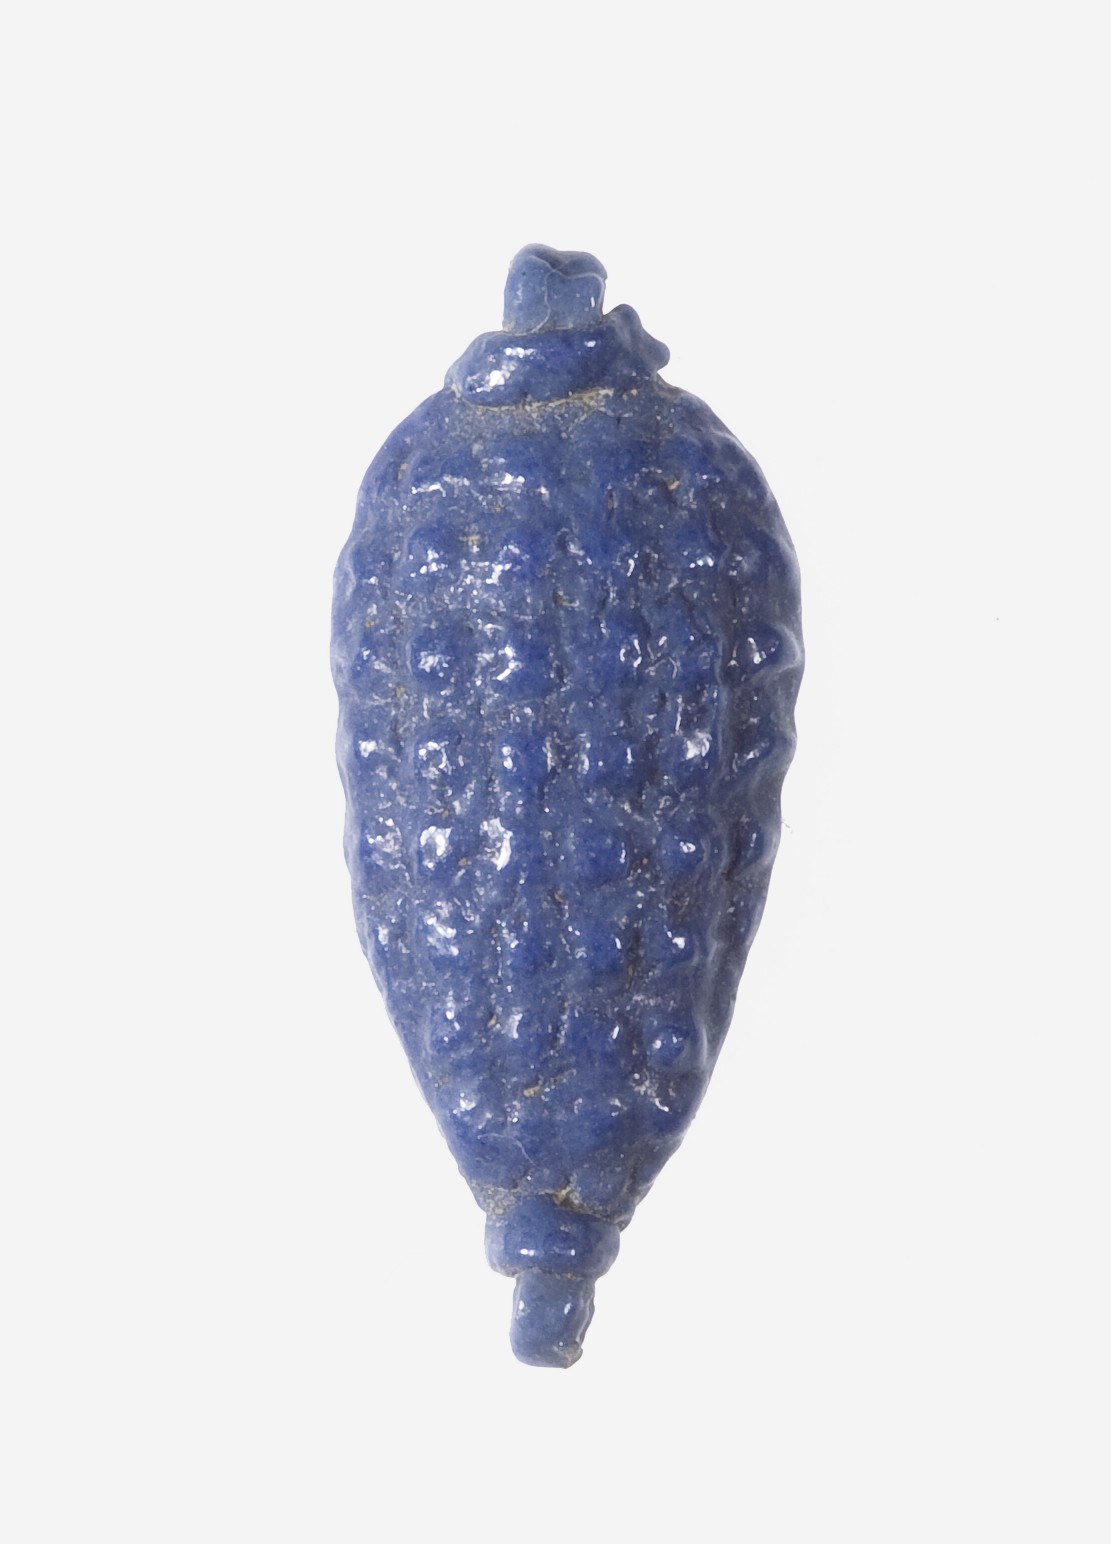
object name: bead, grape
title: Bead in the Form of a Bunch of Grapes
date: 1390-1352 BCE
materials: faience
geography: egypt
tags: grapes